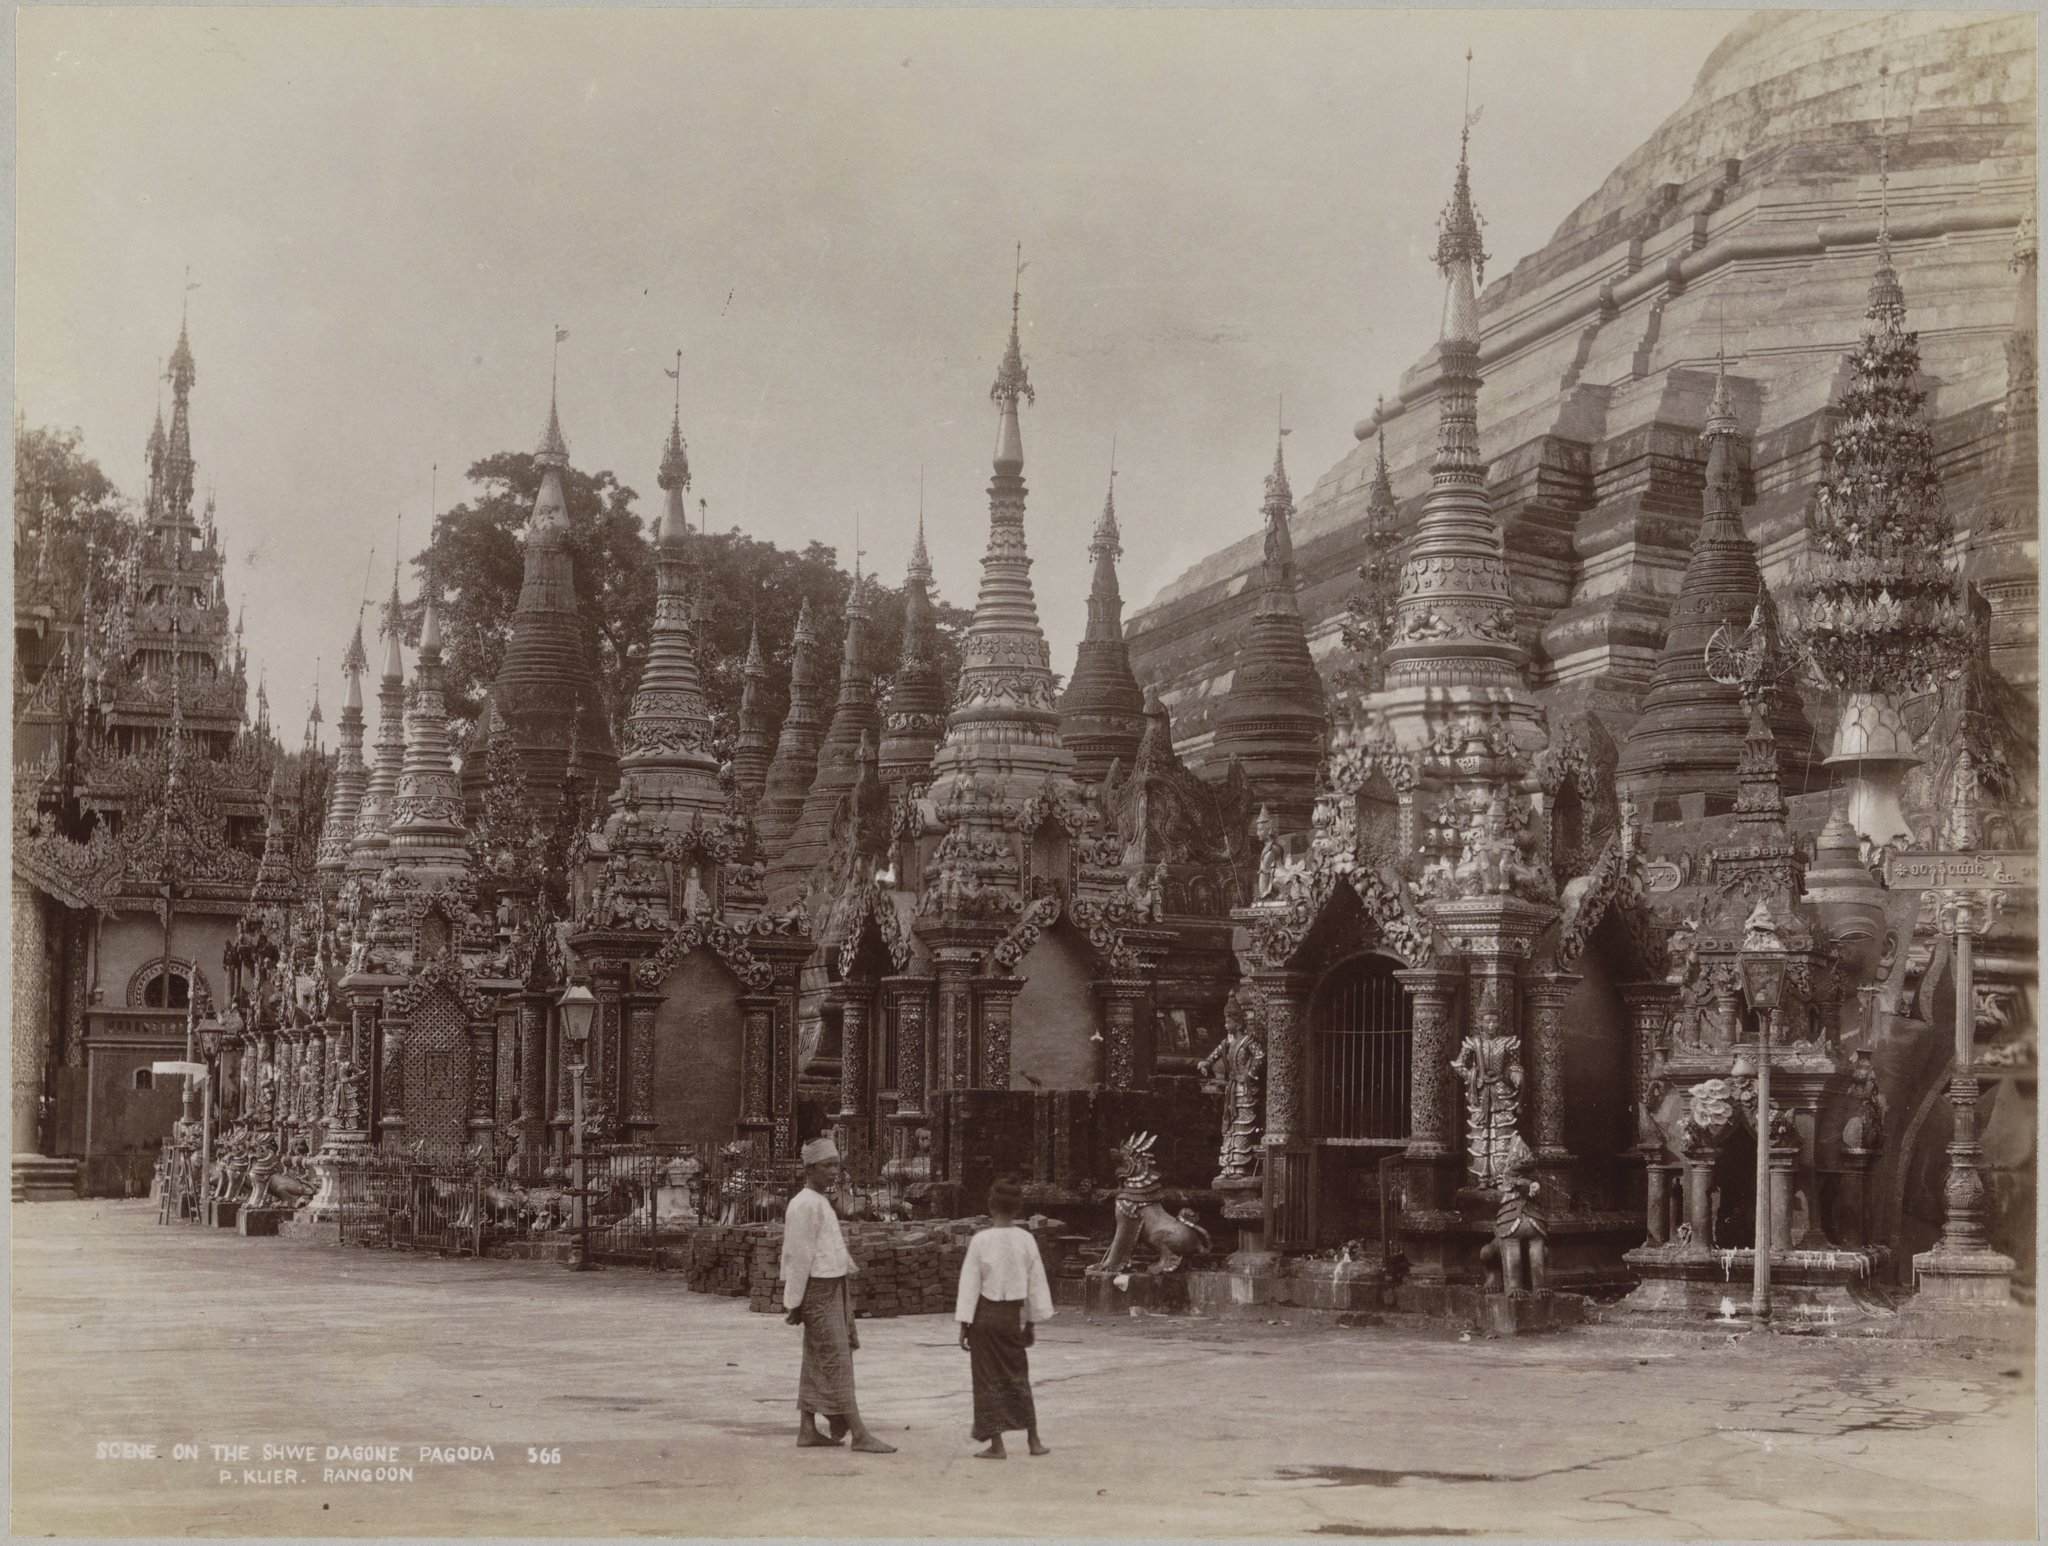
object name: photograph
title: Two people in front of the Shwedagon pagoda, Yangon, Myanmar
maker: philip adolphe klier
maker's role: fotograaf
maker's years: 1845-1911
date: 1895-1915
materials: cardboard, paper, photographic support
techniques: albumen print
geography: yangon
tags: yangon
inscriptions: number: ‘5.’, inscription: ‘Scene on the Shwe Dagone Pagoda 566/ P. Klier. Rangoon’